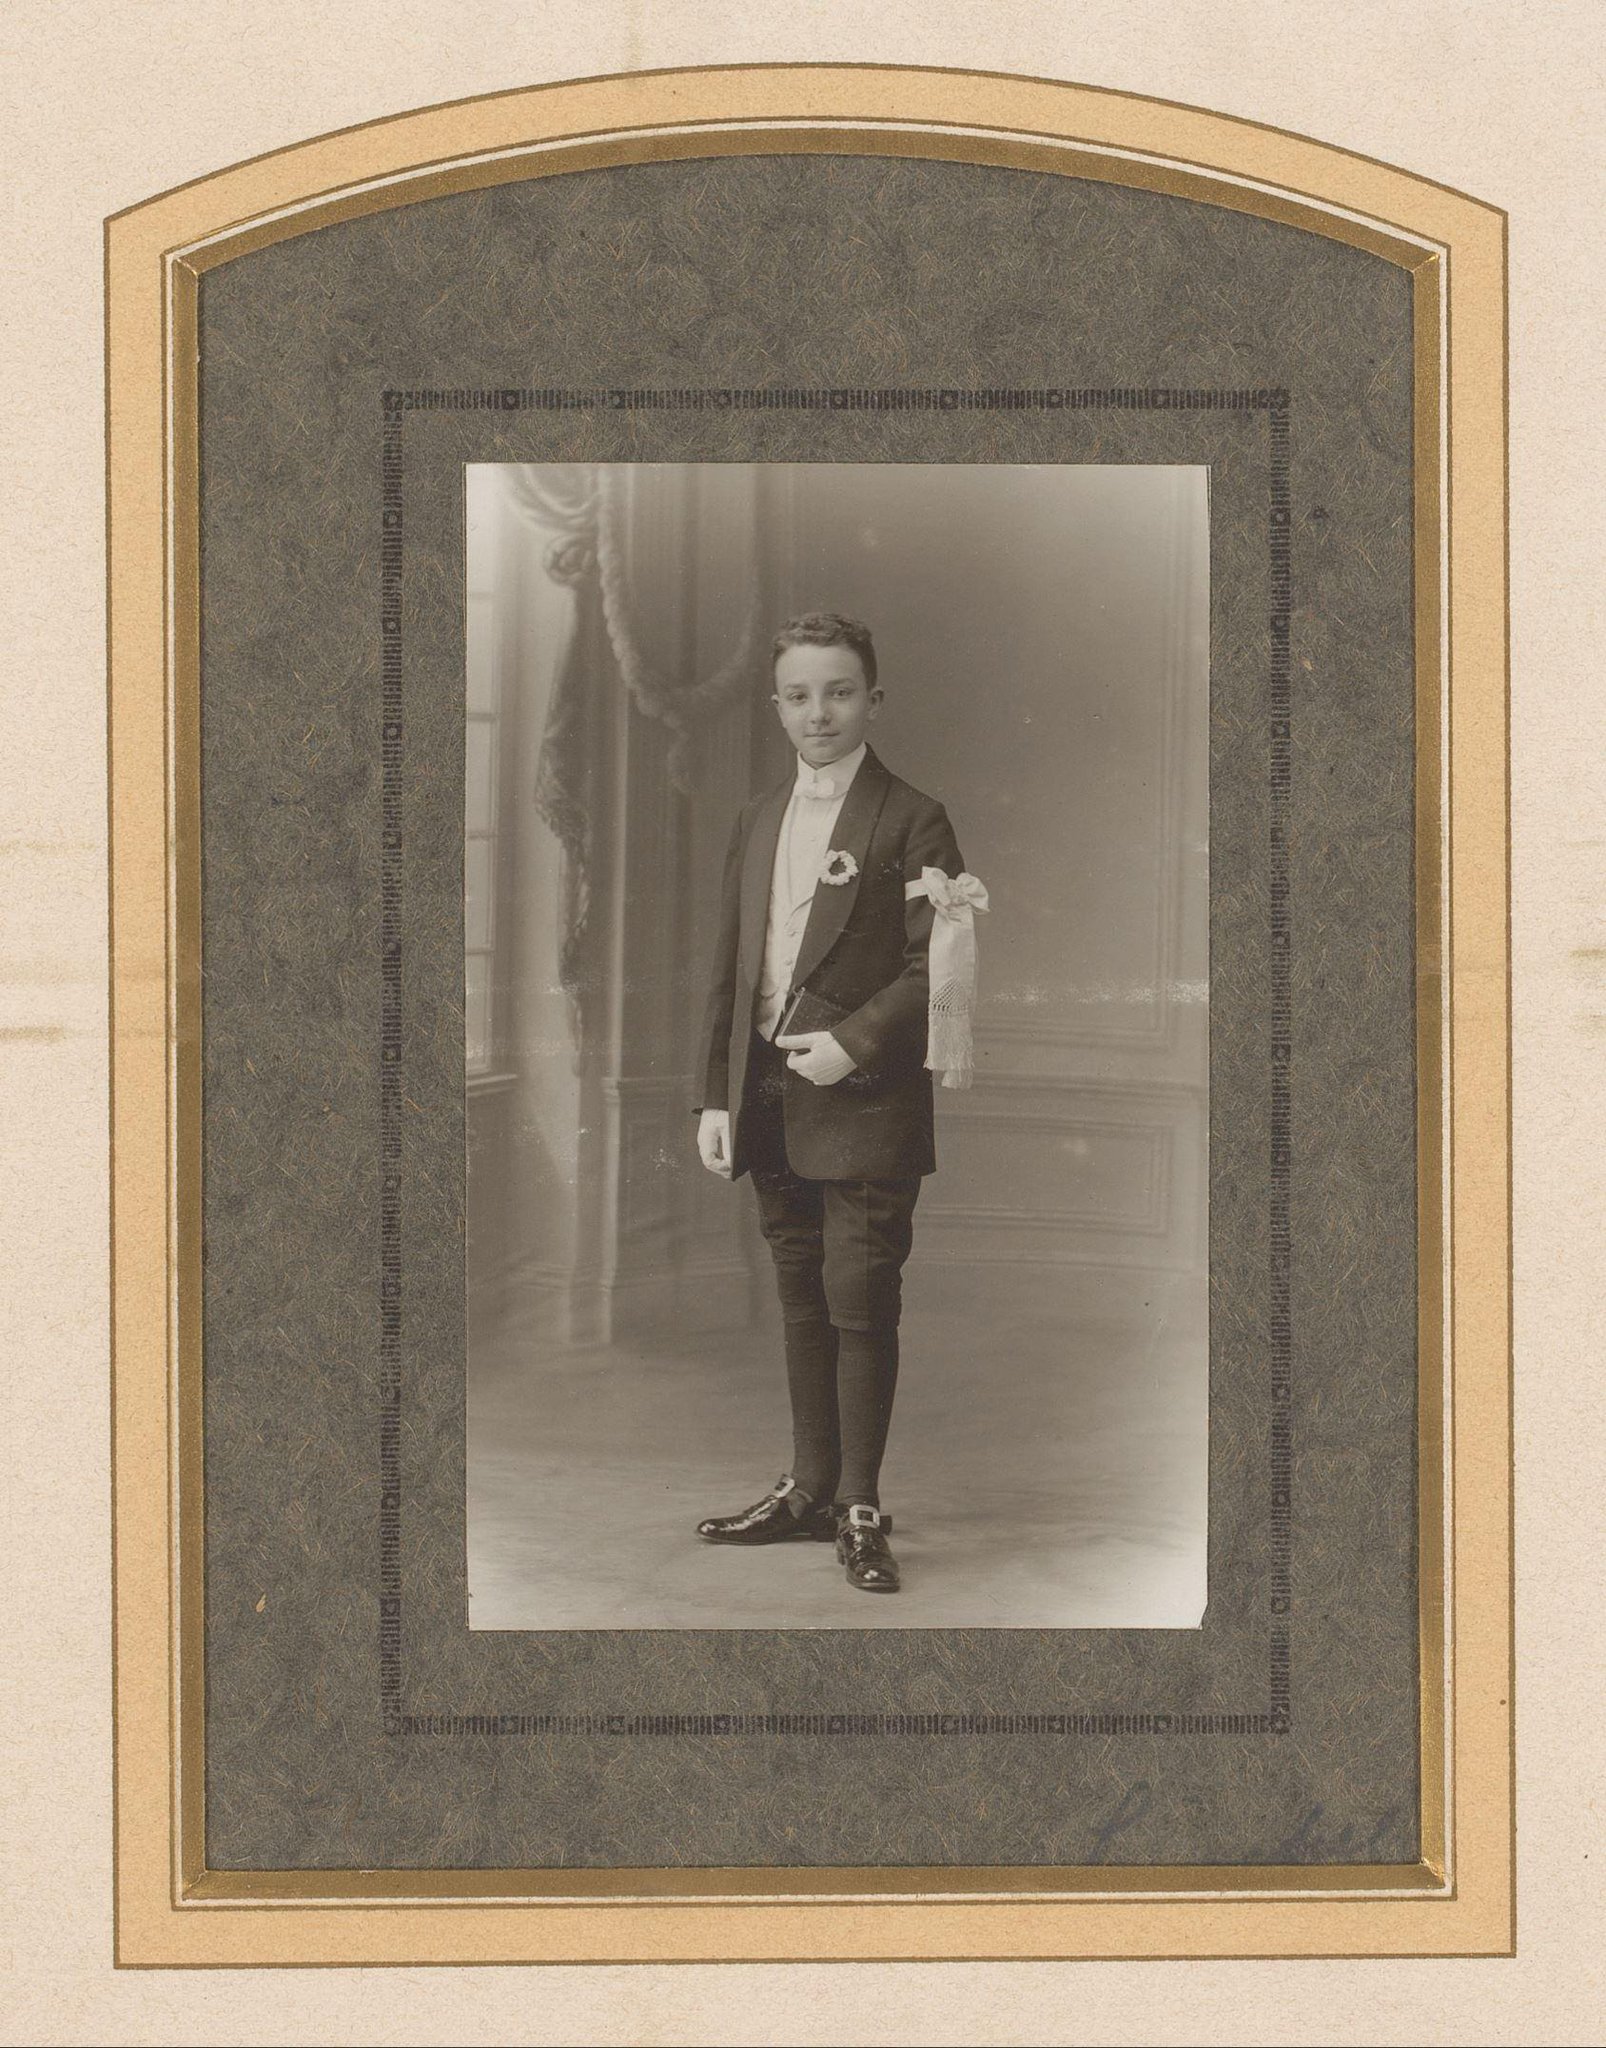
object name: album leaf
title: Portret van een jongen met een witte strik om de arm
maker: Anonymous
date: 1870-1900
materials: cardboard, photographic support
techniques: gelatin silver print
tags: boy (child between toddler and youth), historical persons, clothes for special purposes